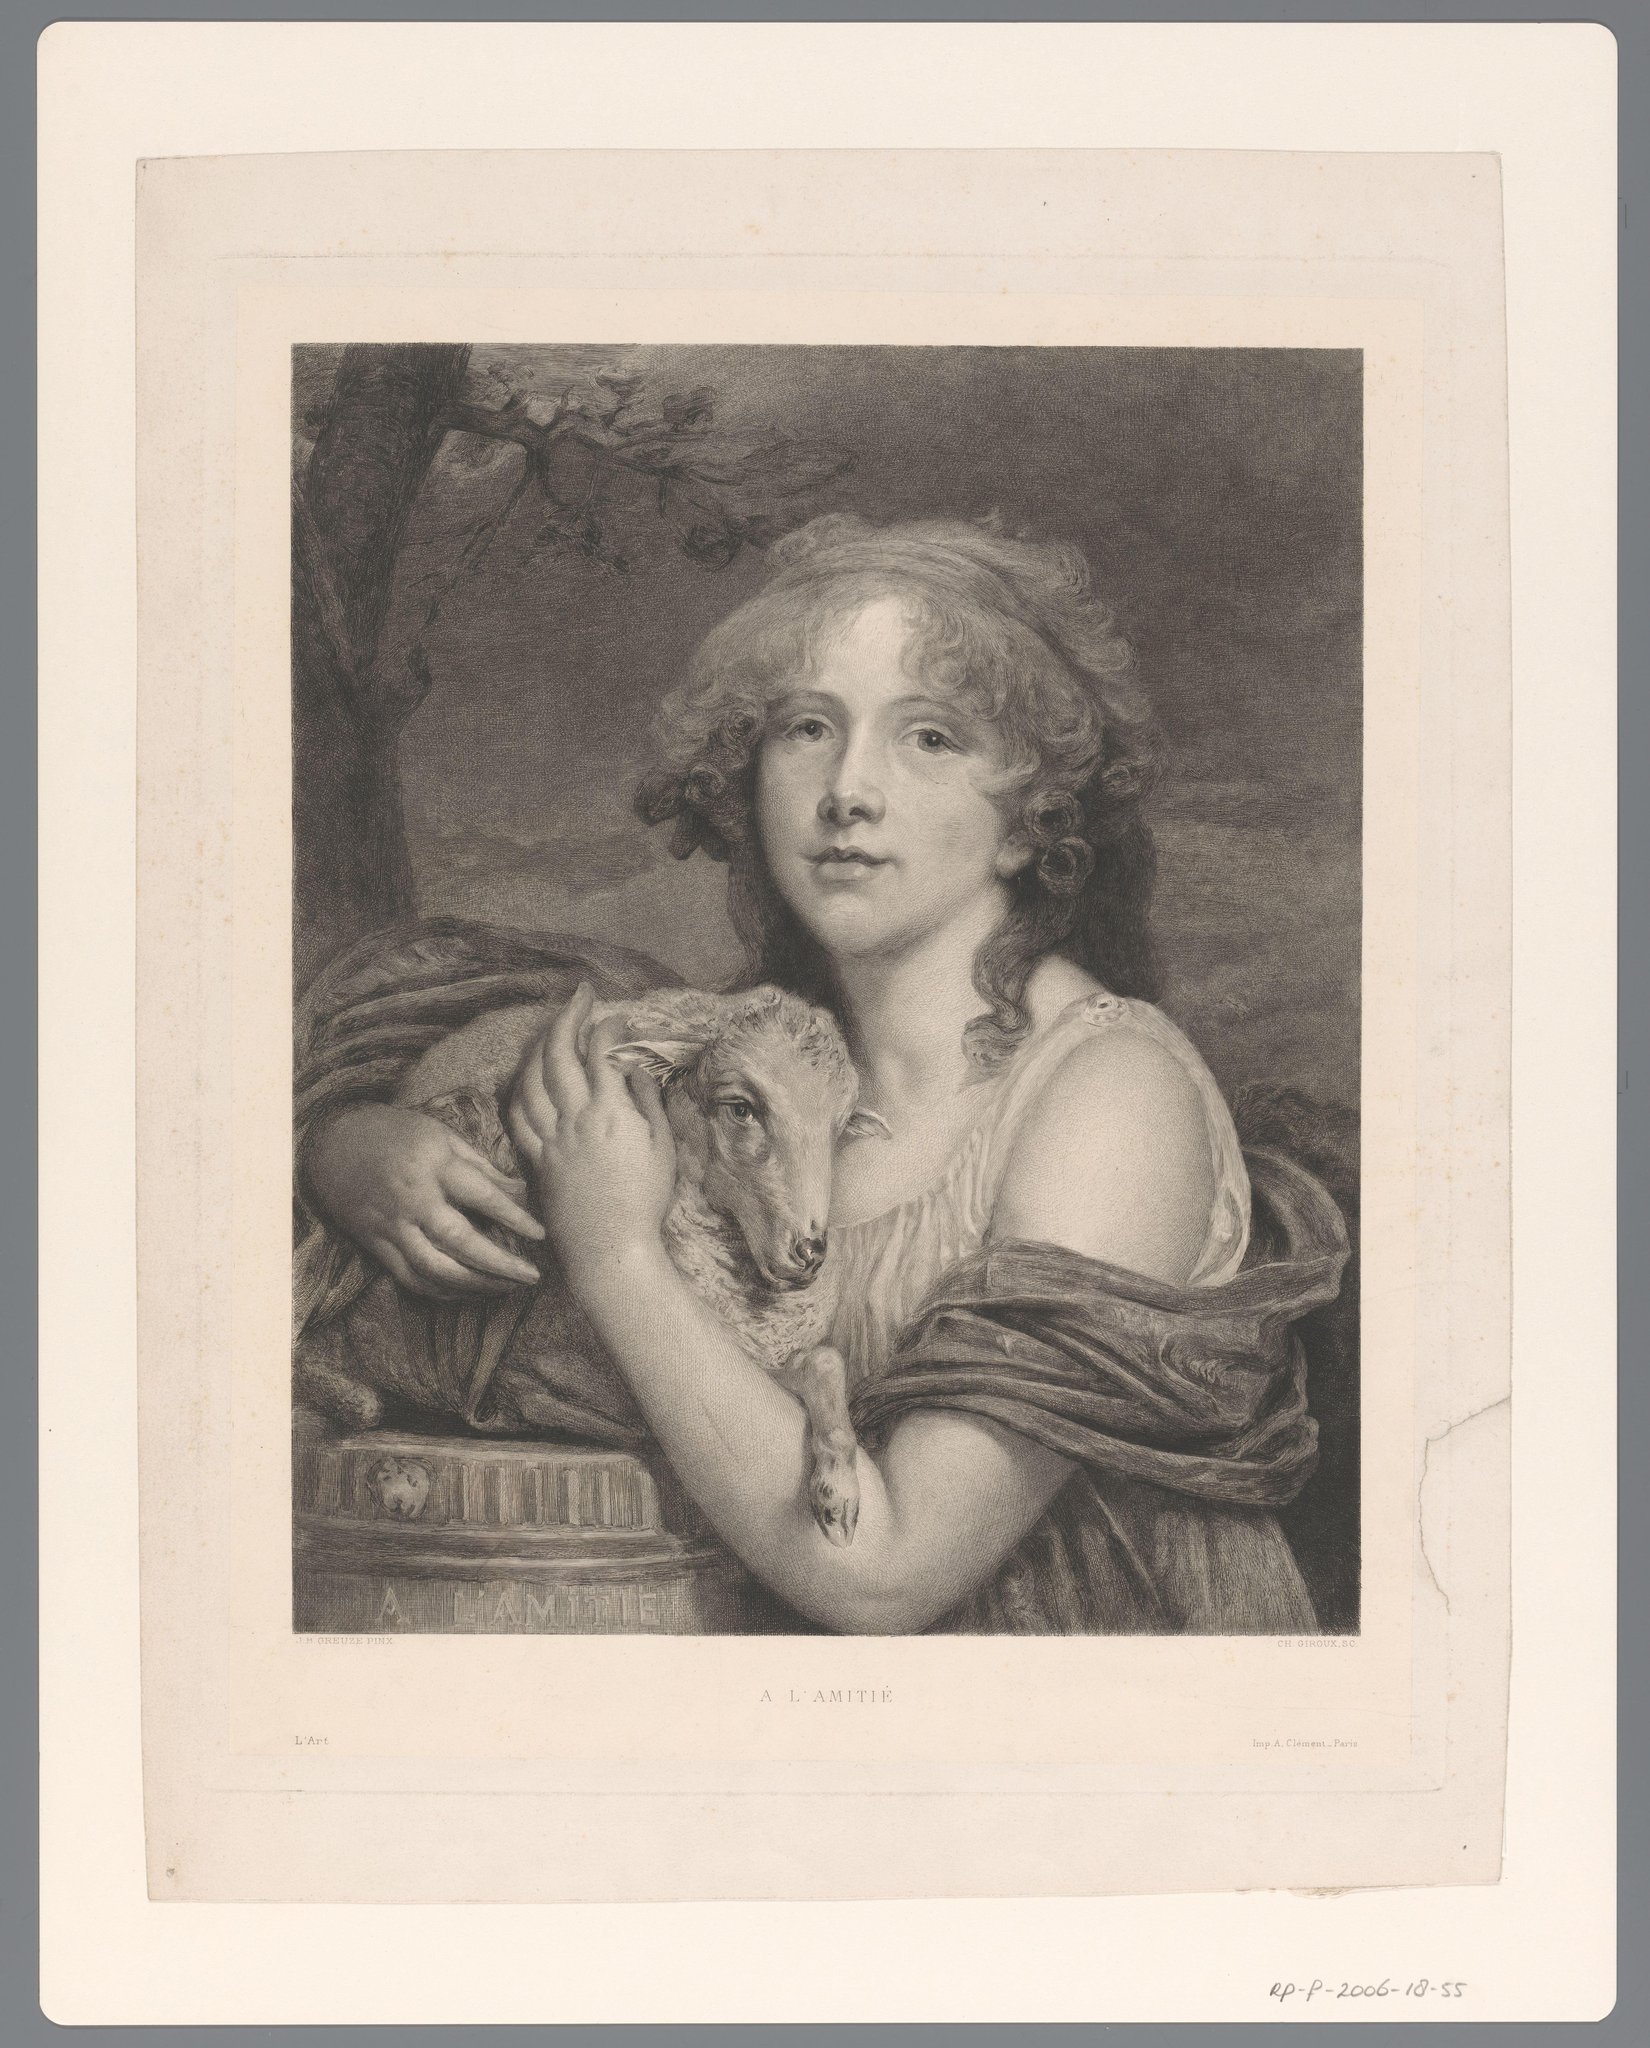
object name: print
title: A l'amitié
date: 1800-1900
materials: cardboard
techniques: lithograph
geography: paris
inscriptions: : ‘J.B. GREUZE PINX. CH. GIROUX. SC / A L'AMITIÉ / L'ART Imp. A. Clément-Paris’